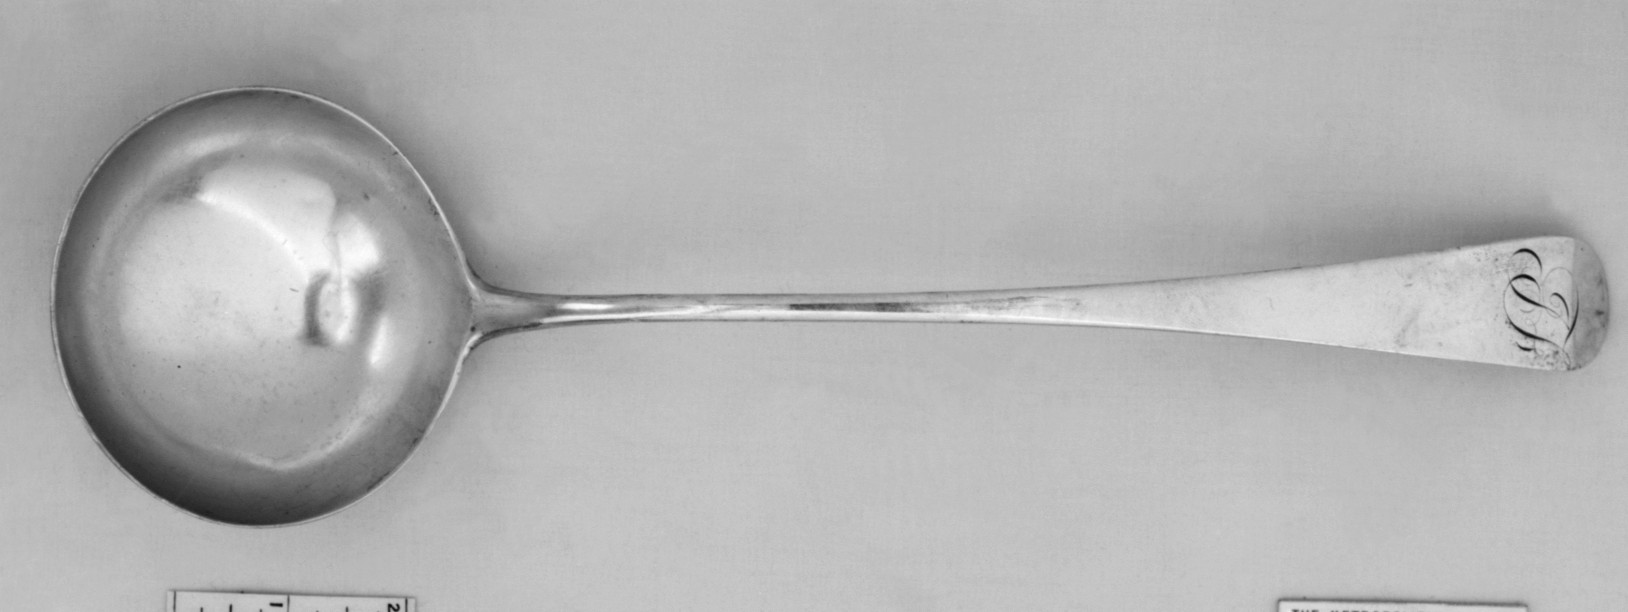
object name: ladle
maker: john lambe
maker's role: maker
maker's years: 1774-1796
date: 1781-1782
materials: silver